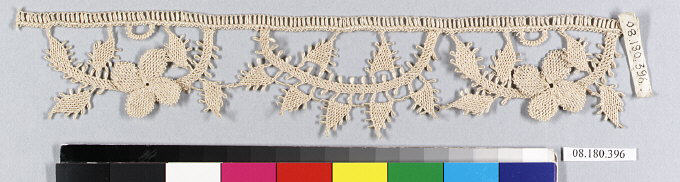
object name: fragment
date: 1801-1900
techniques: lace